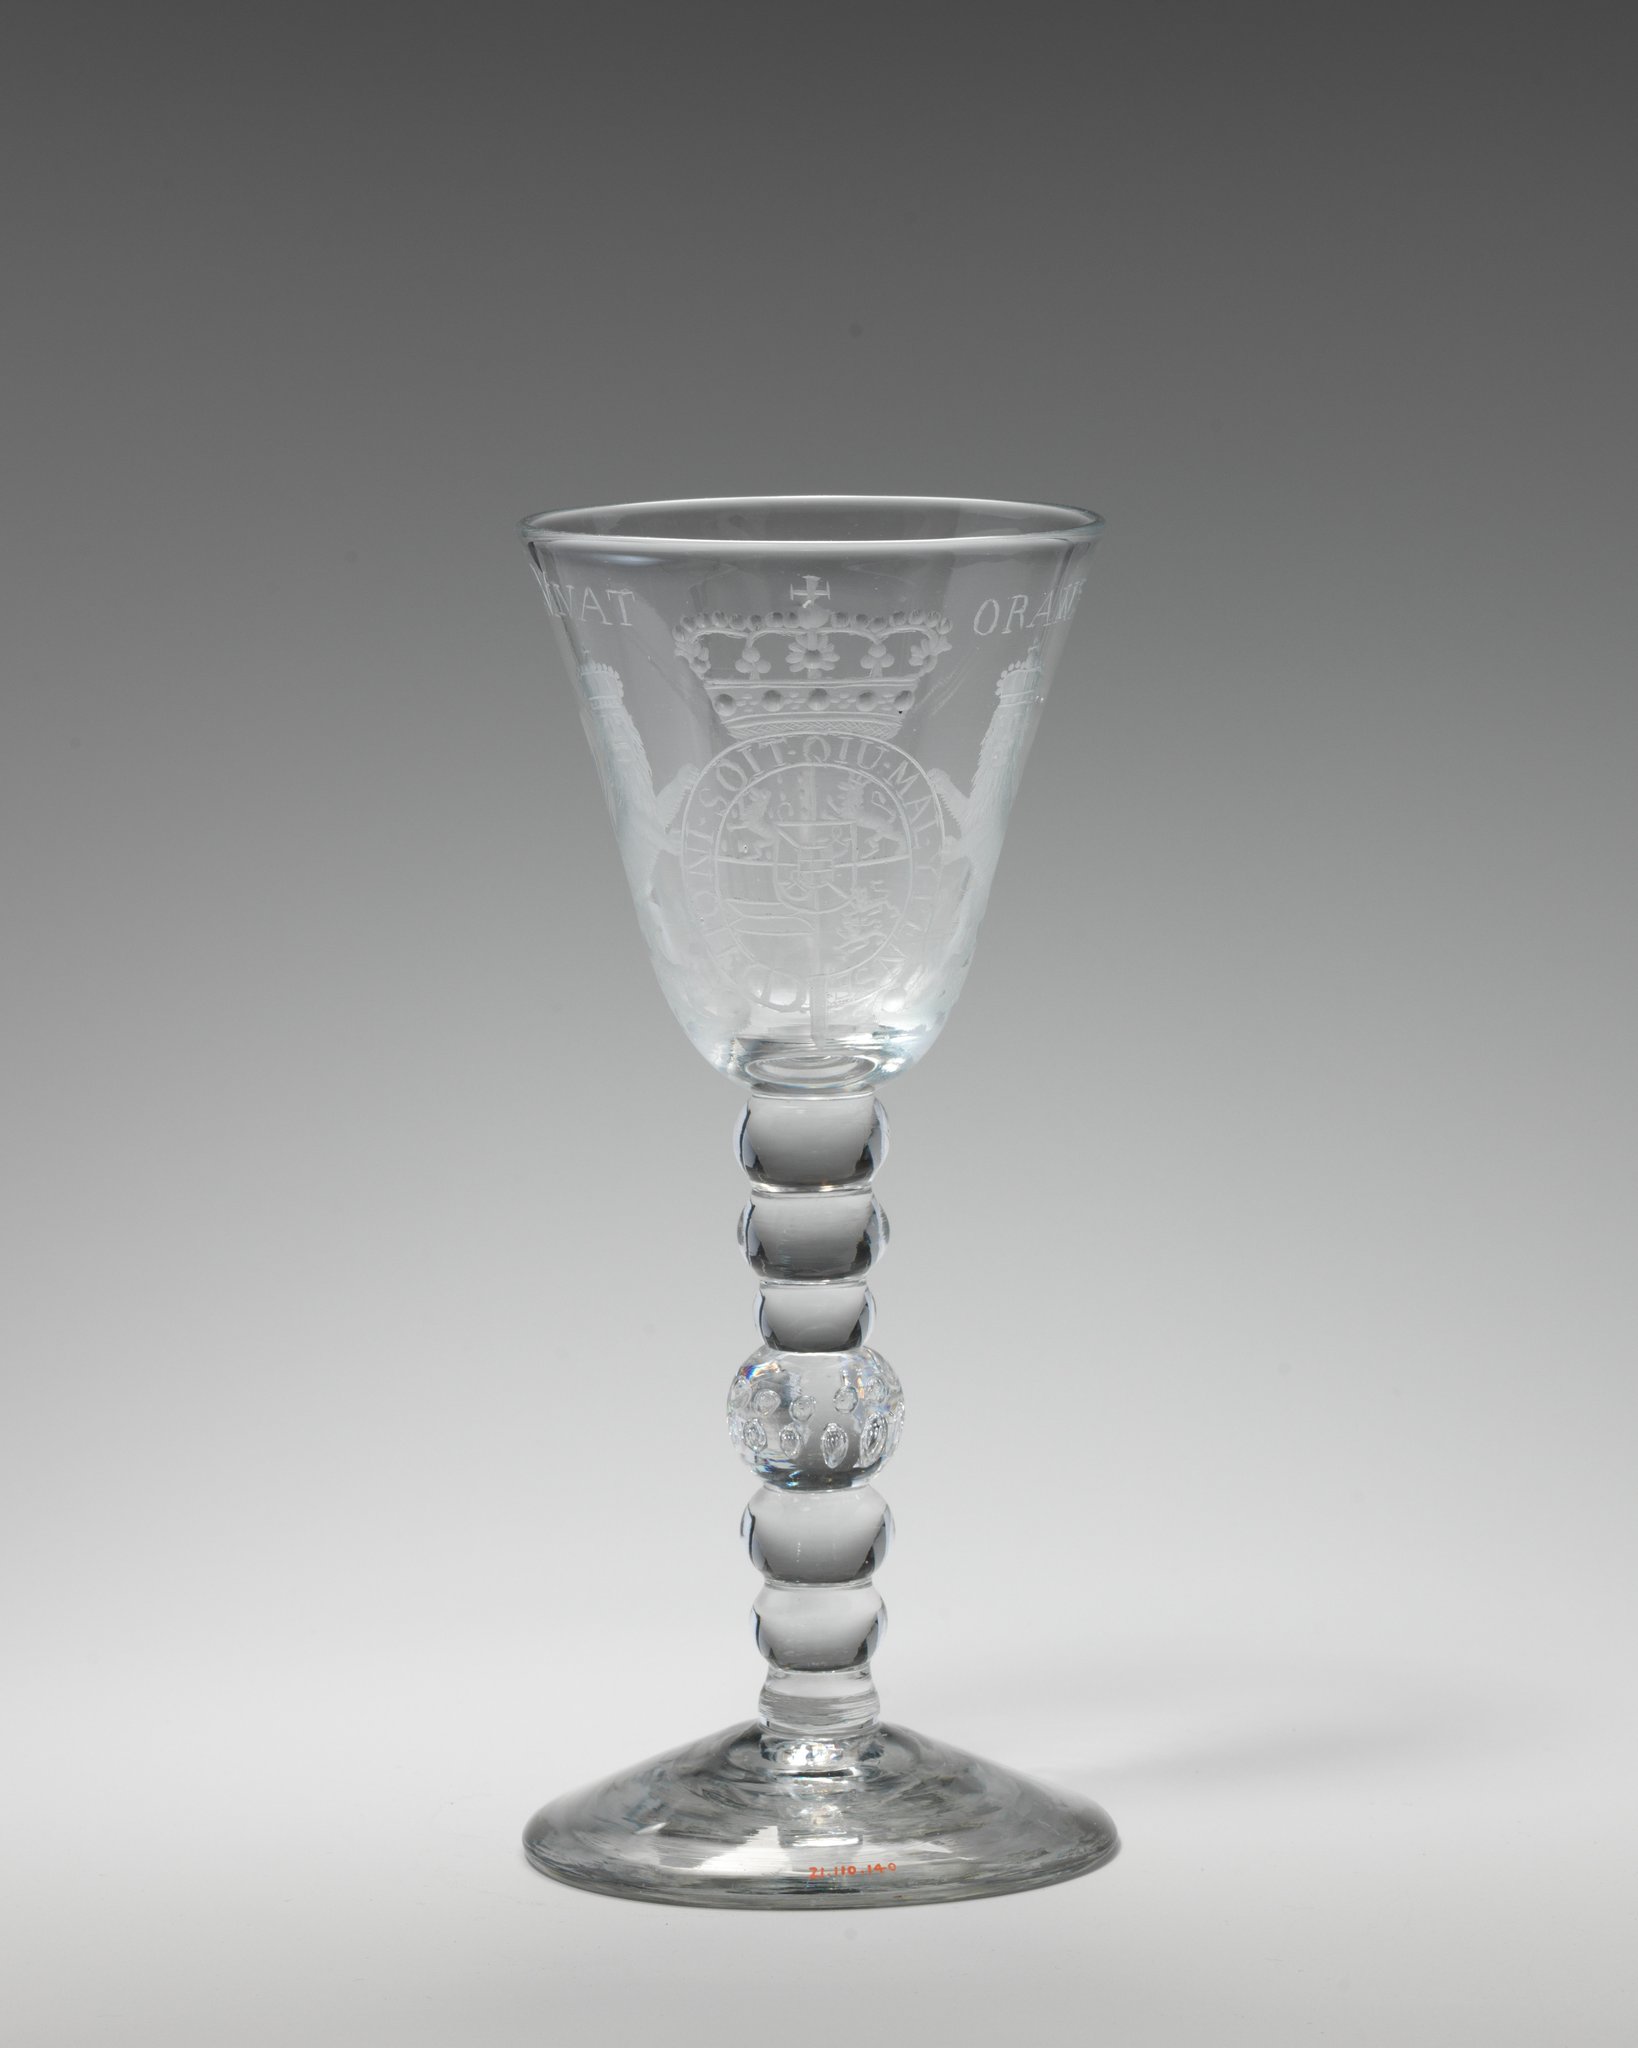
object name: wineglass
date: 1735-1751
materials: glass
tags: coat of arms